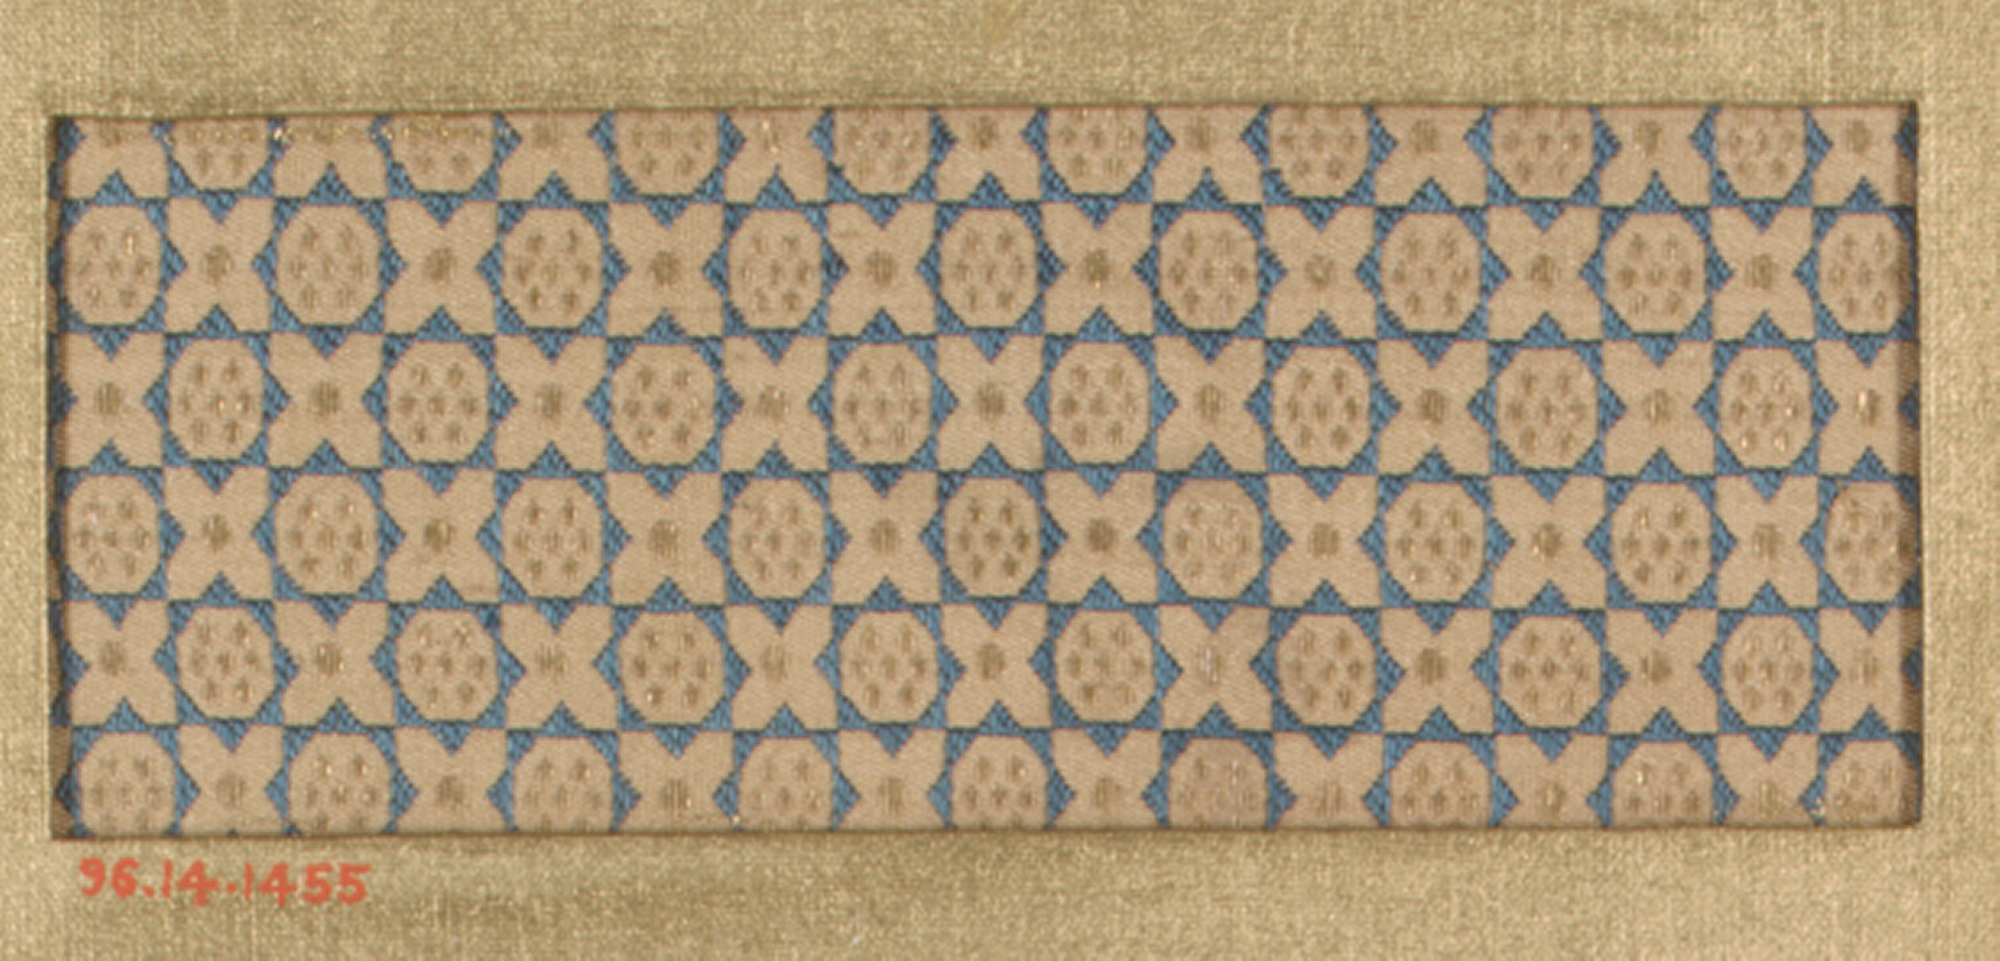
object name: piece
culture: japanese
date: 1701-1900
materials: silk